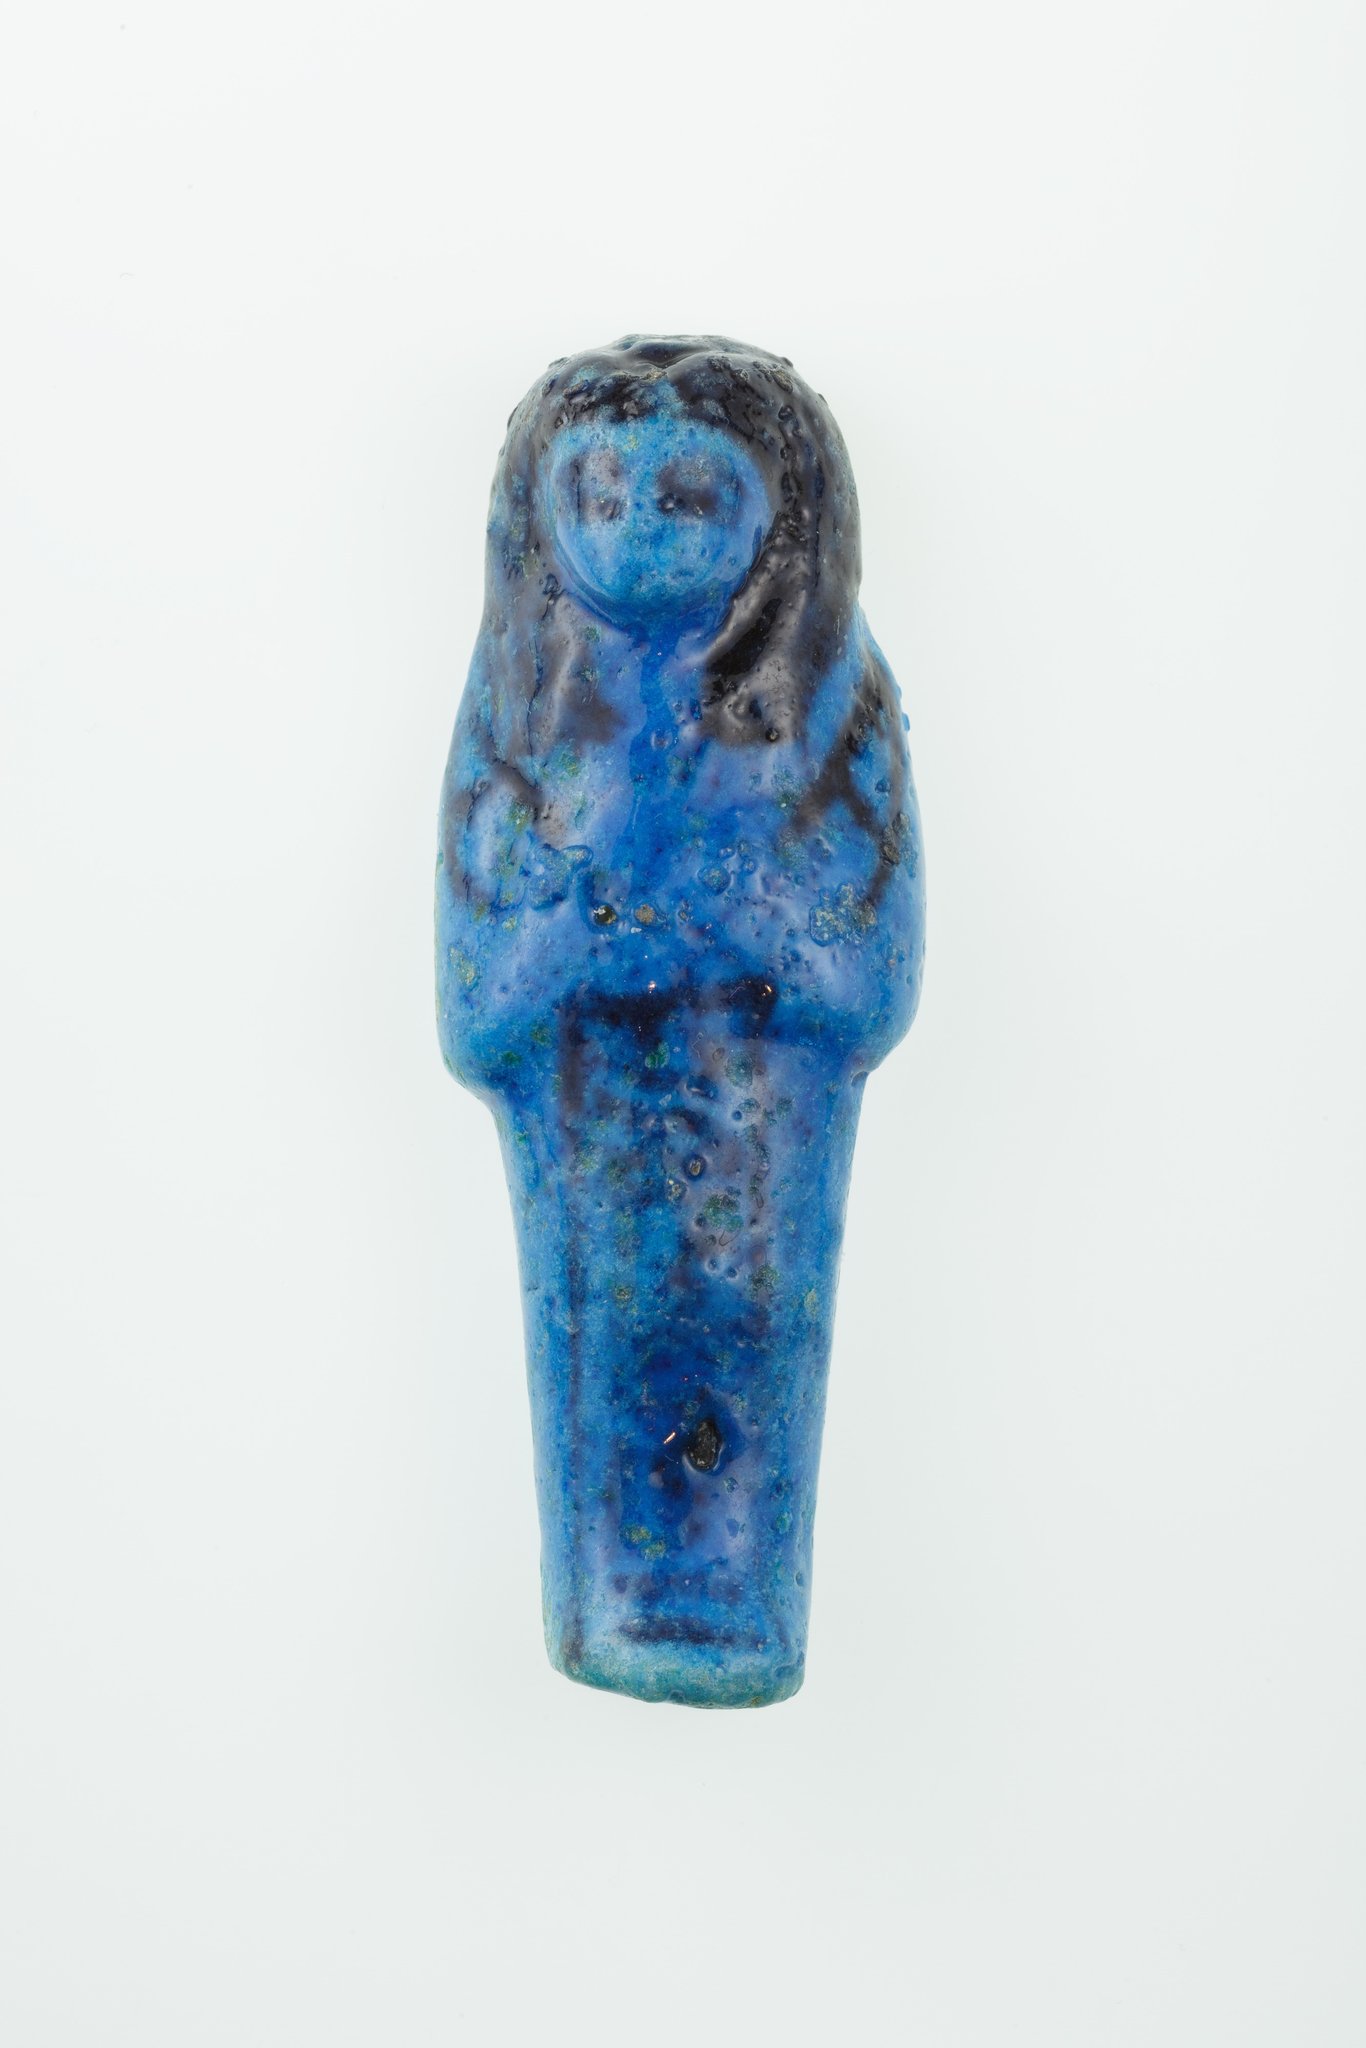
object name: shabti, worker, nauny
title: Worker Shabti of Nauny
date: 1050 BCE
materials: faience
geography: egypt